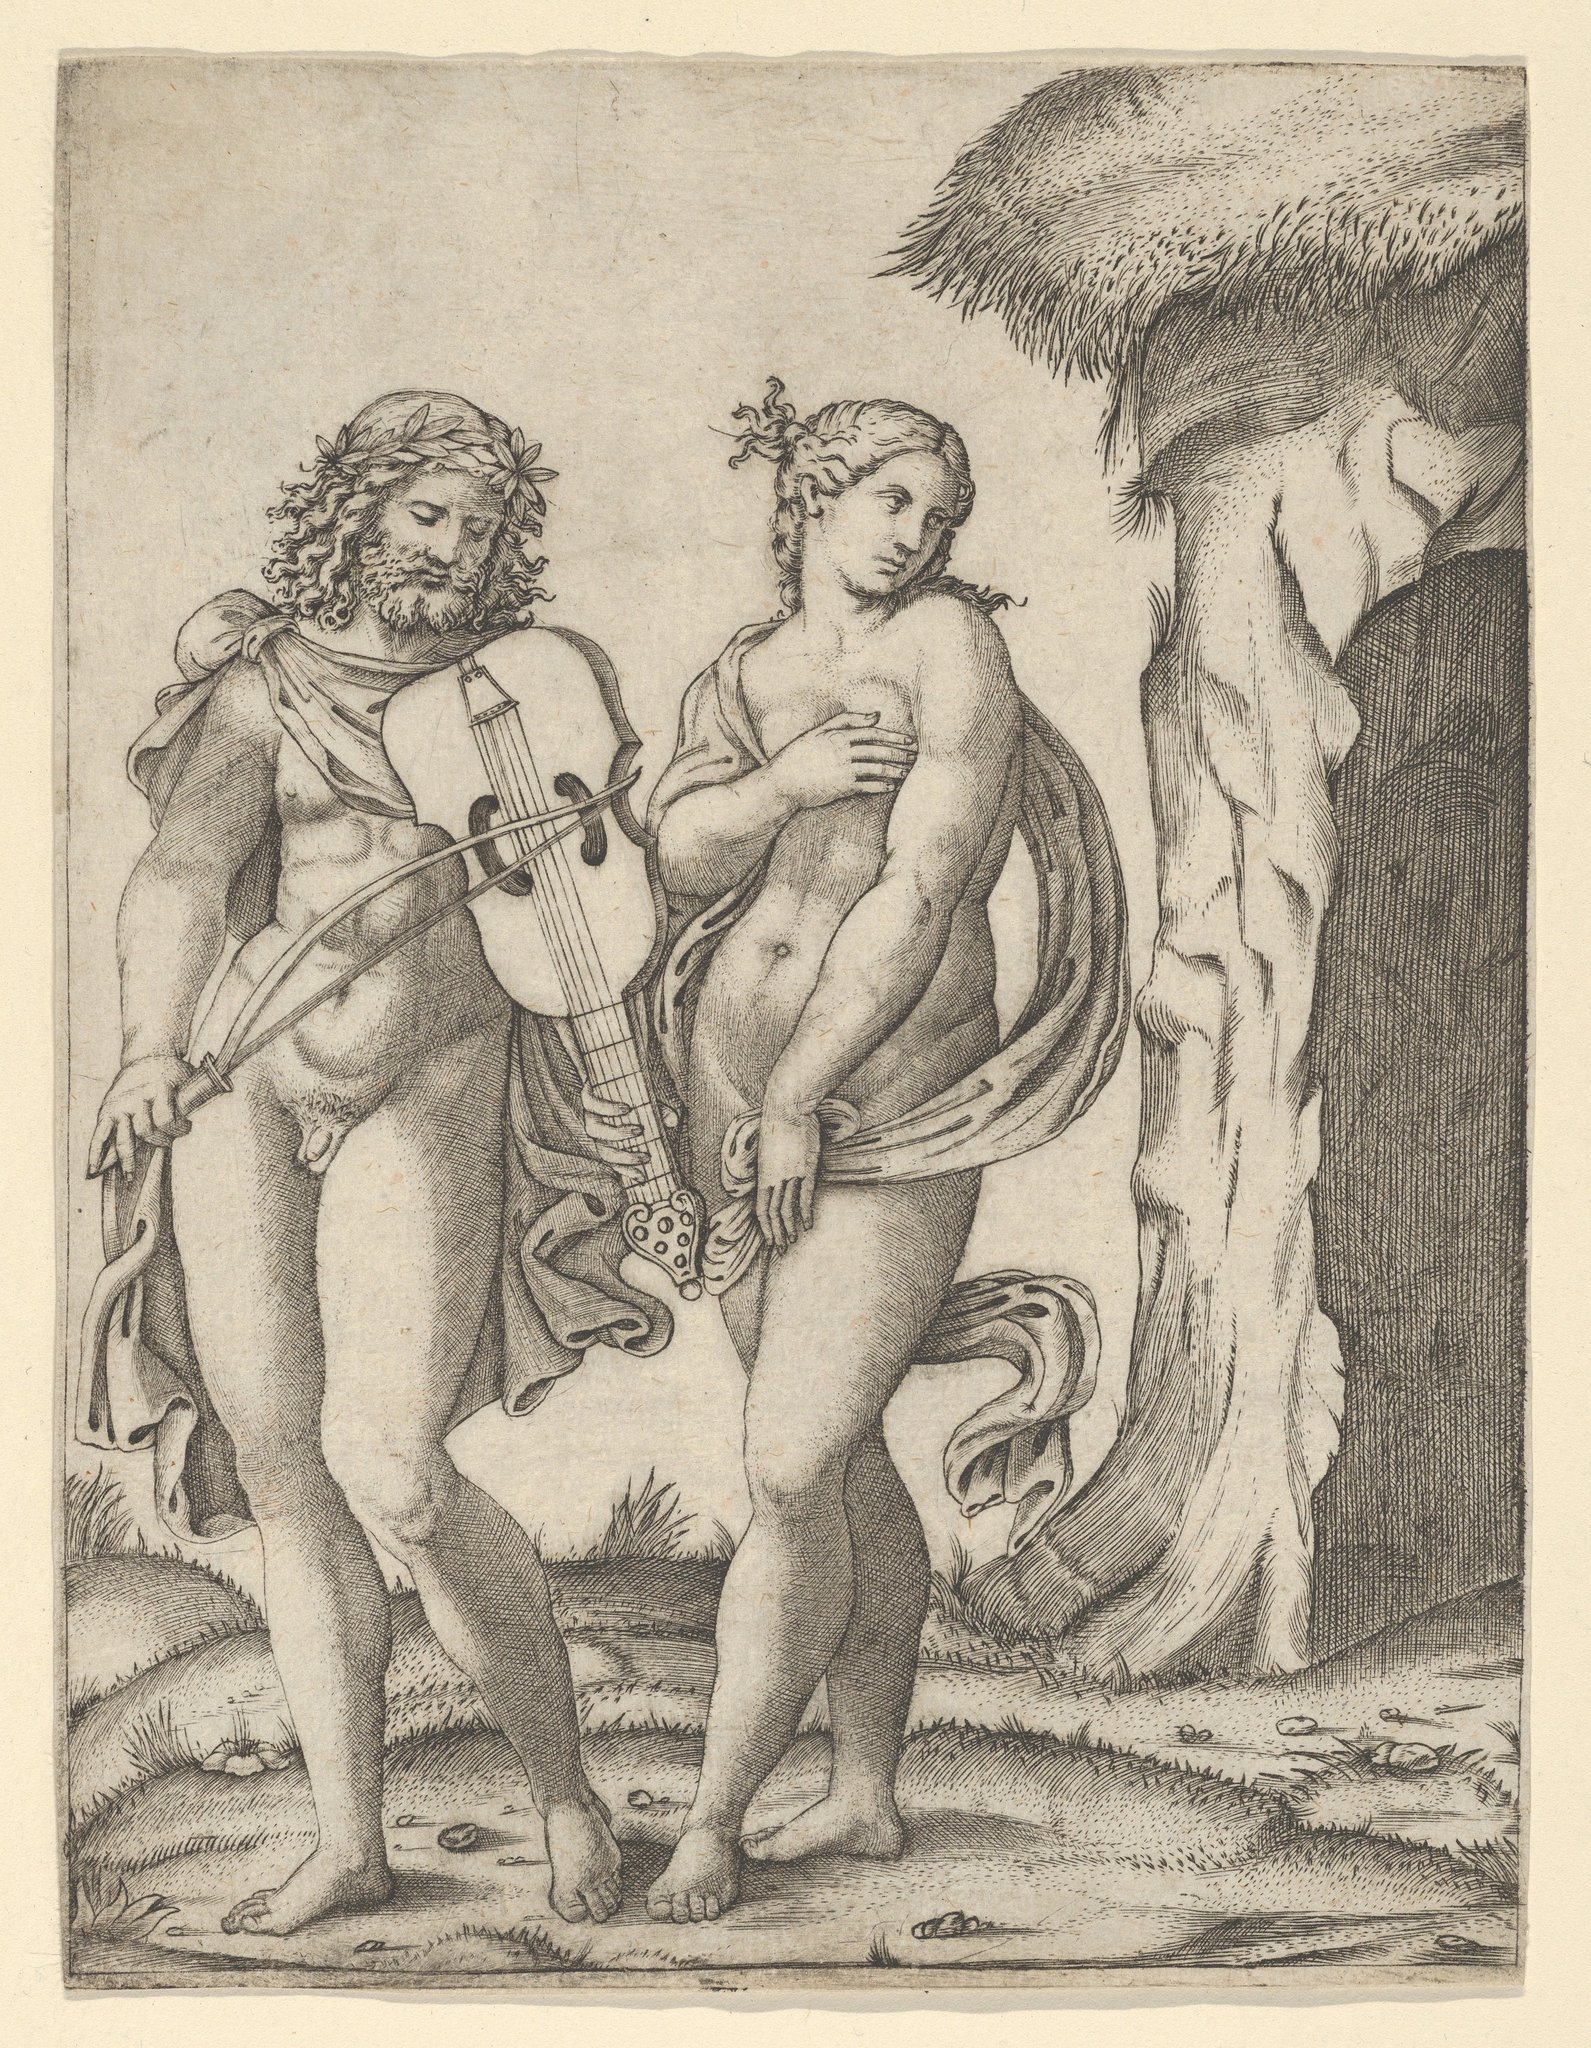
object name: print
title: Orpheus standing at left playing the violin, Eurydice at right covering herself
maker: marcantonio raimondi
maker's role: artist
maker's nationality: italian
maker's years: 1475-1534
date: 1509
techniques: engraving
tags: male nudes,female nudes,violins,orpheus,eurydice